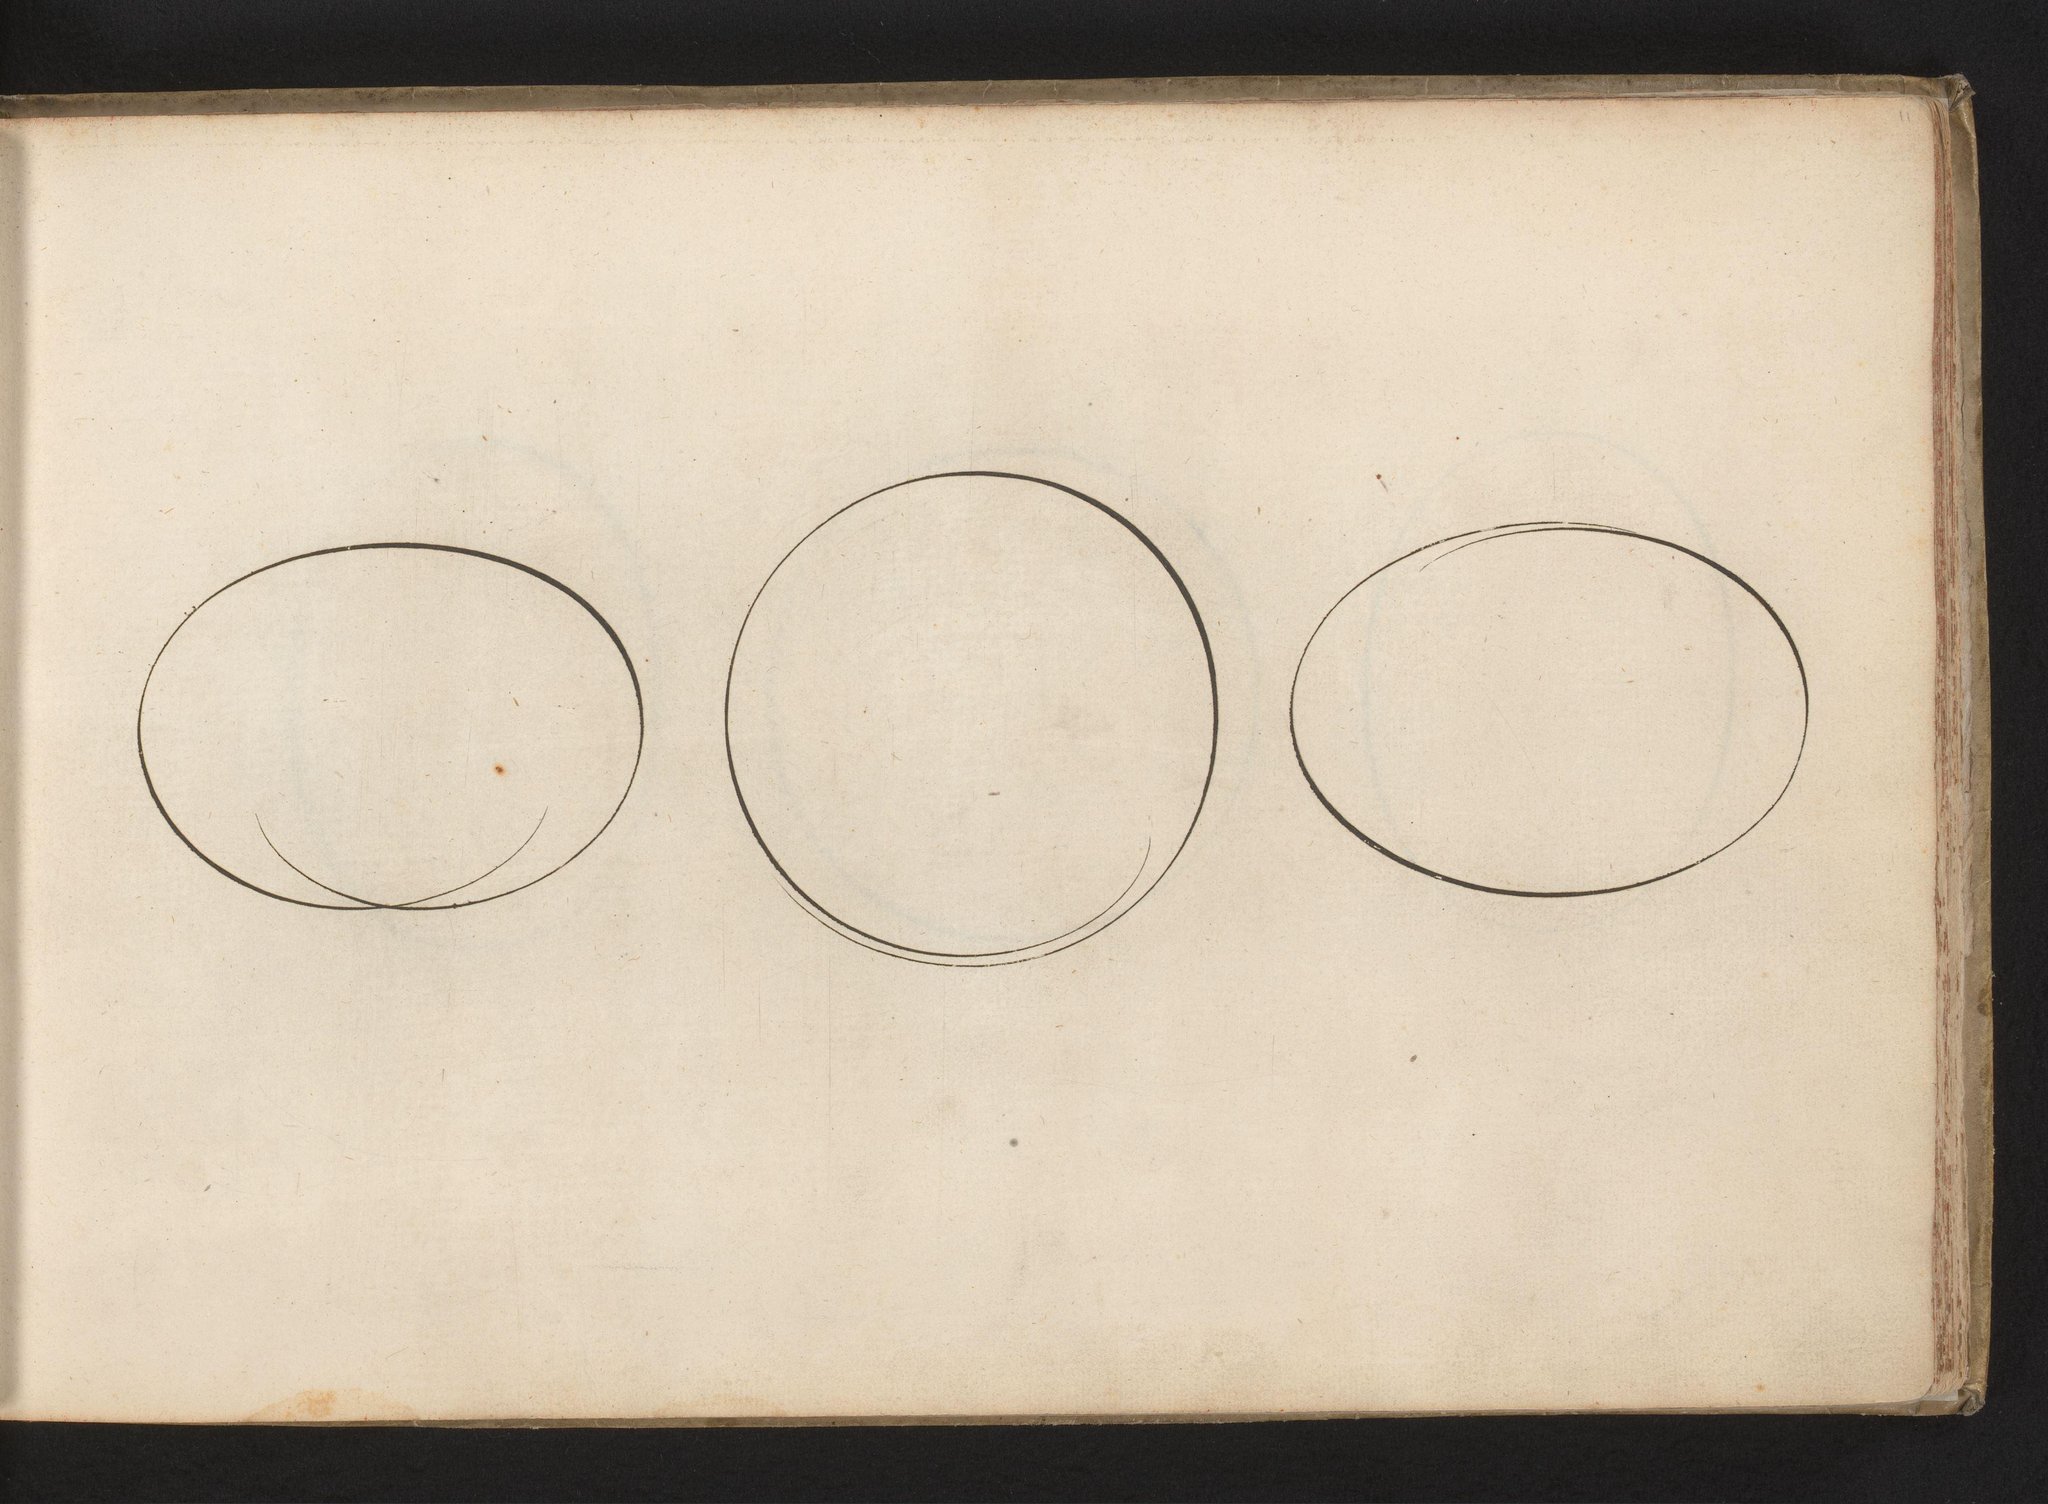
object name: album leaf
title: Spieghel der schrijfkonste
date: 1605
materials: paper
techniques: engraving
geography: haarlem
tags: calligraphy, circle (~ planimetry, geometry)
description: Een liggende open ovaal, gevolgd door een open cirkel en een liggende open ovaal. De prent maakt deel uit van een album.